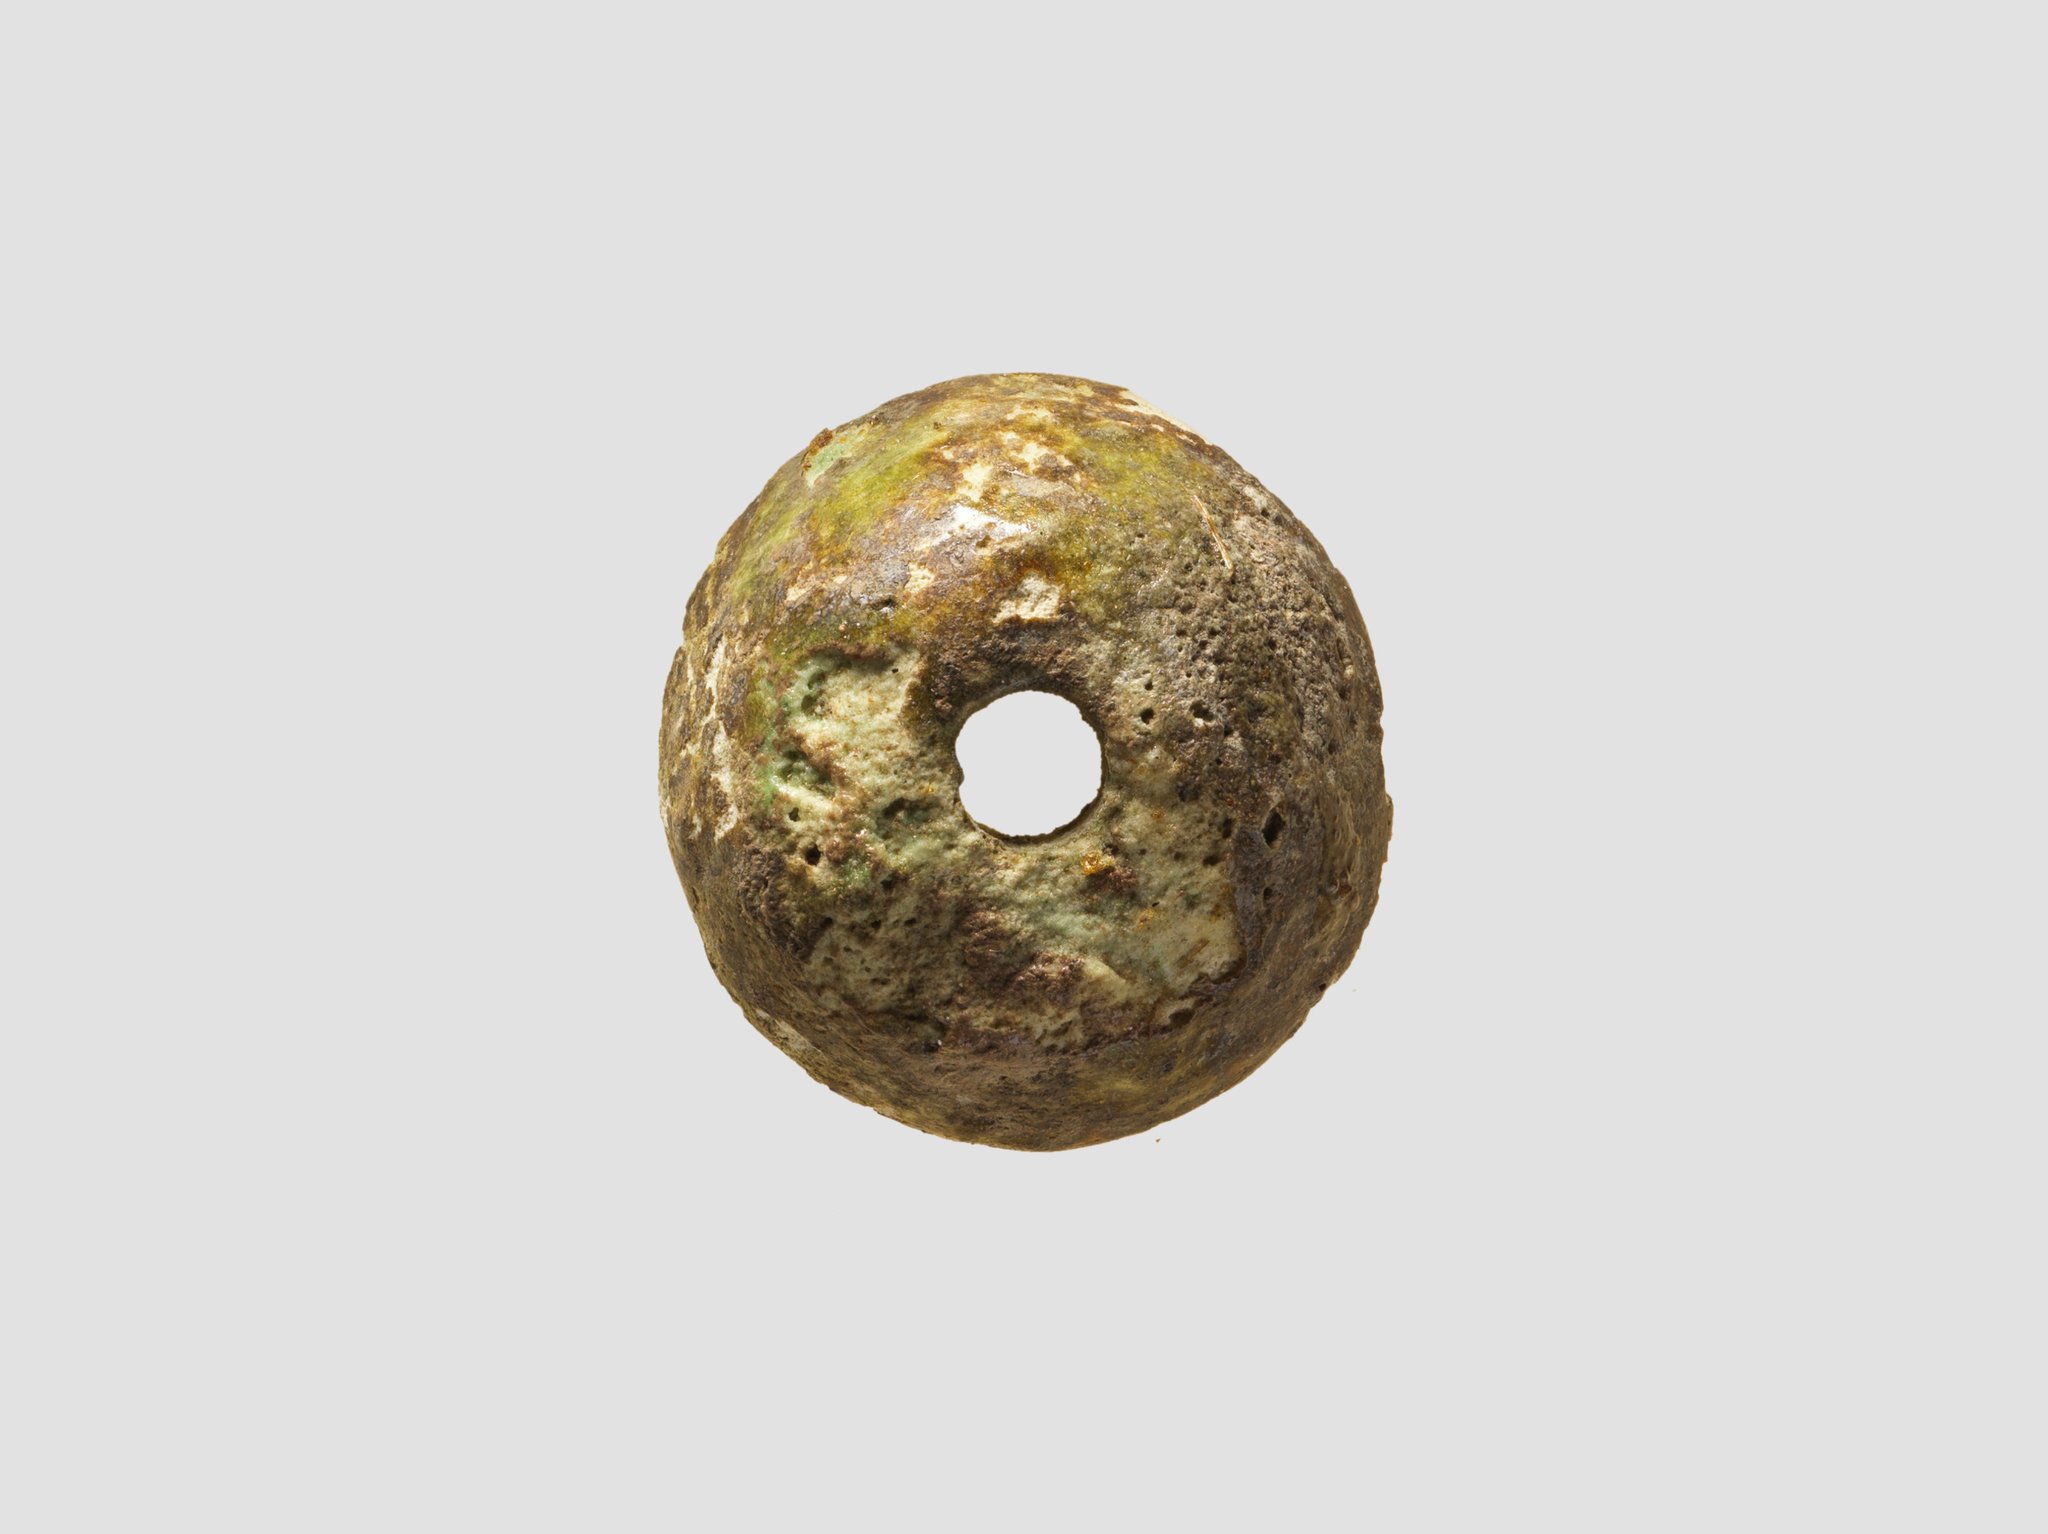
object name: button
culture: assyrian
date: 900-601 BCE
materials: ceramic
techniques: glazing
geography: mesopotamia